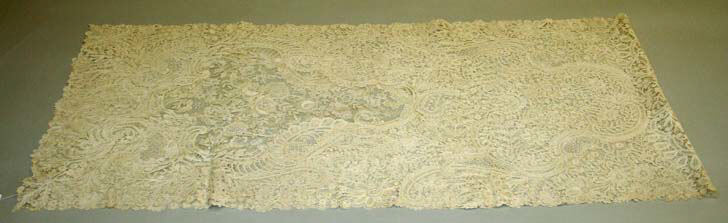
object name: scarf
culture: belgian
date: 1867-1900